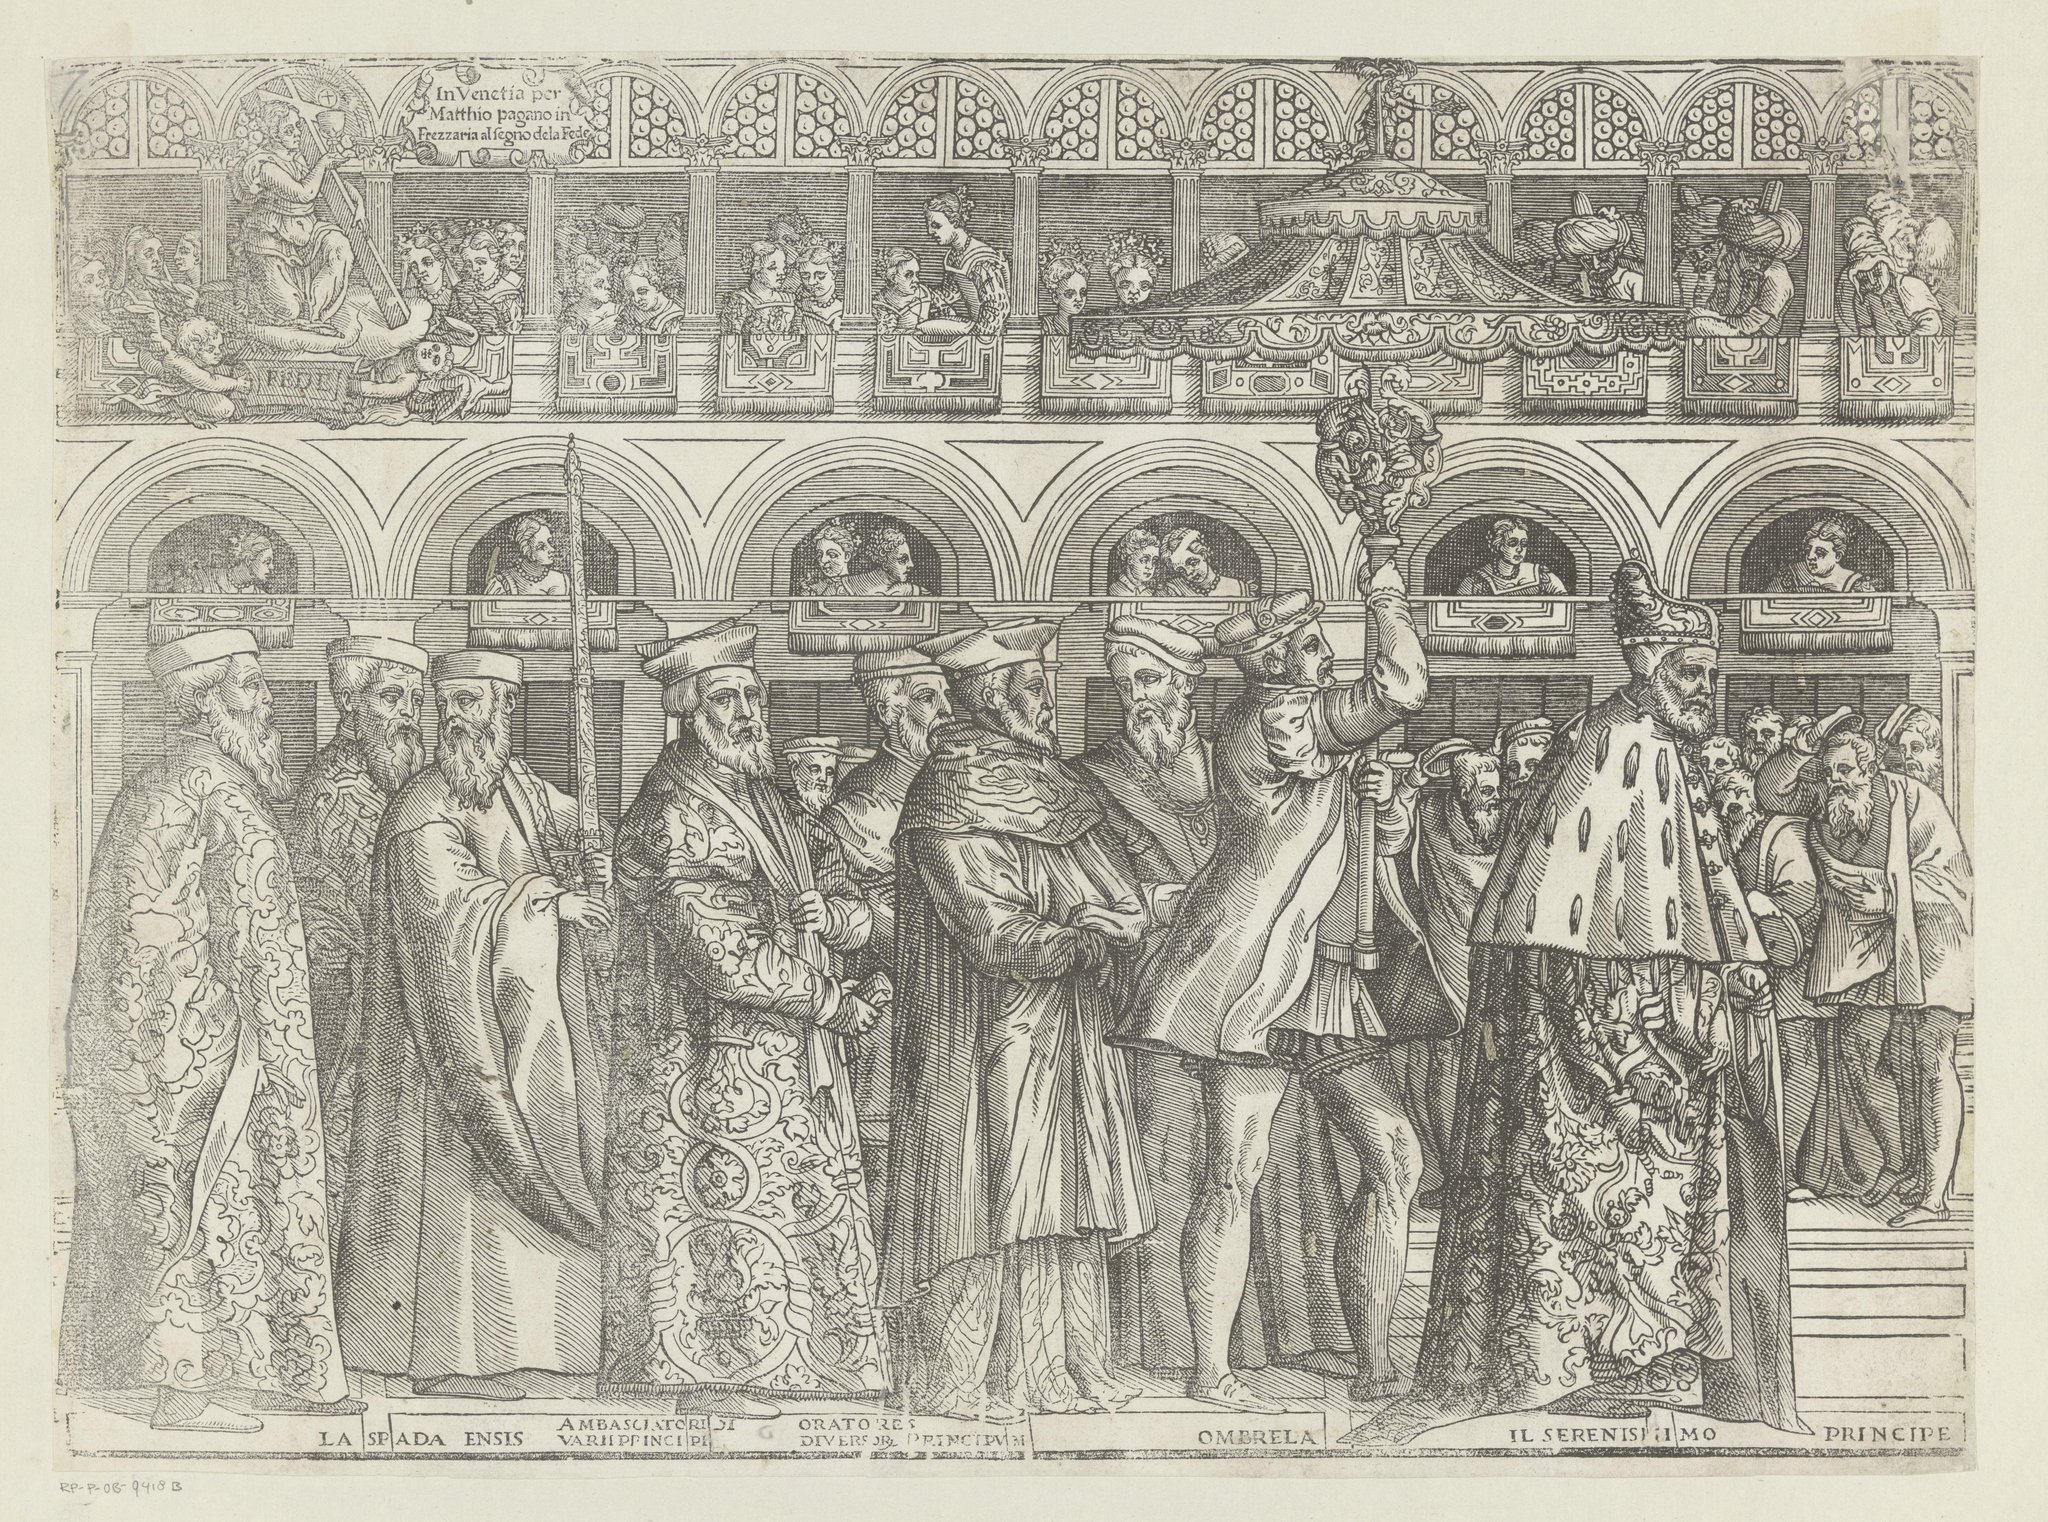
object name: print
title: Processie van de doge van Venetië (tweede deel)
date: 1555-1560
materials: paper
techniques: woodcut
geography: venice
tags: faith, 'fides'; 'fede', 'fede catholica', 'fede christiana', 'fede christiana catholica' (ripa) ~ one of the three theological virtues, procession ~ christian religion, other sovereign: doge, venice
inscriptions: collector's mark: Lugt 2228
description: Deze prent maakt deel uit van een fries bestaande uit acht prenten die samen een processie van de Doge van Venetië vormen.